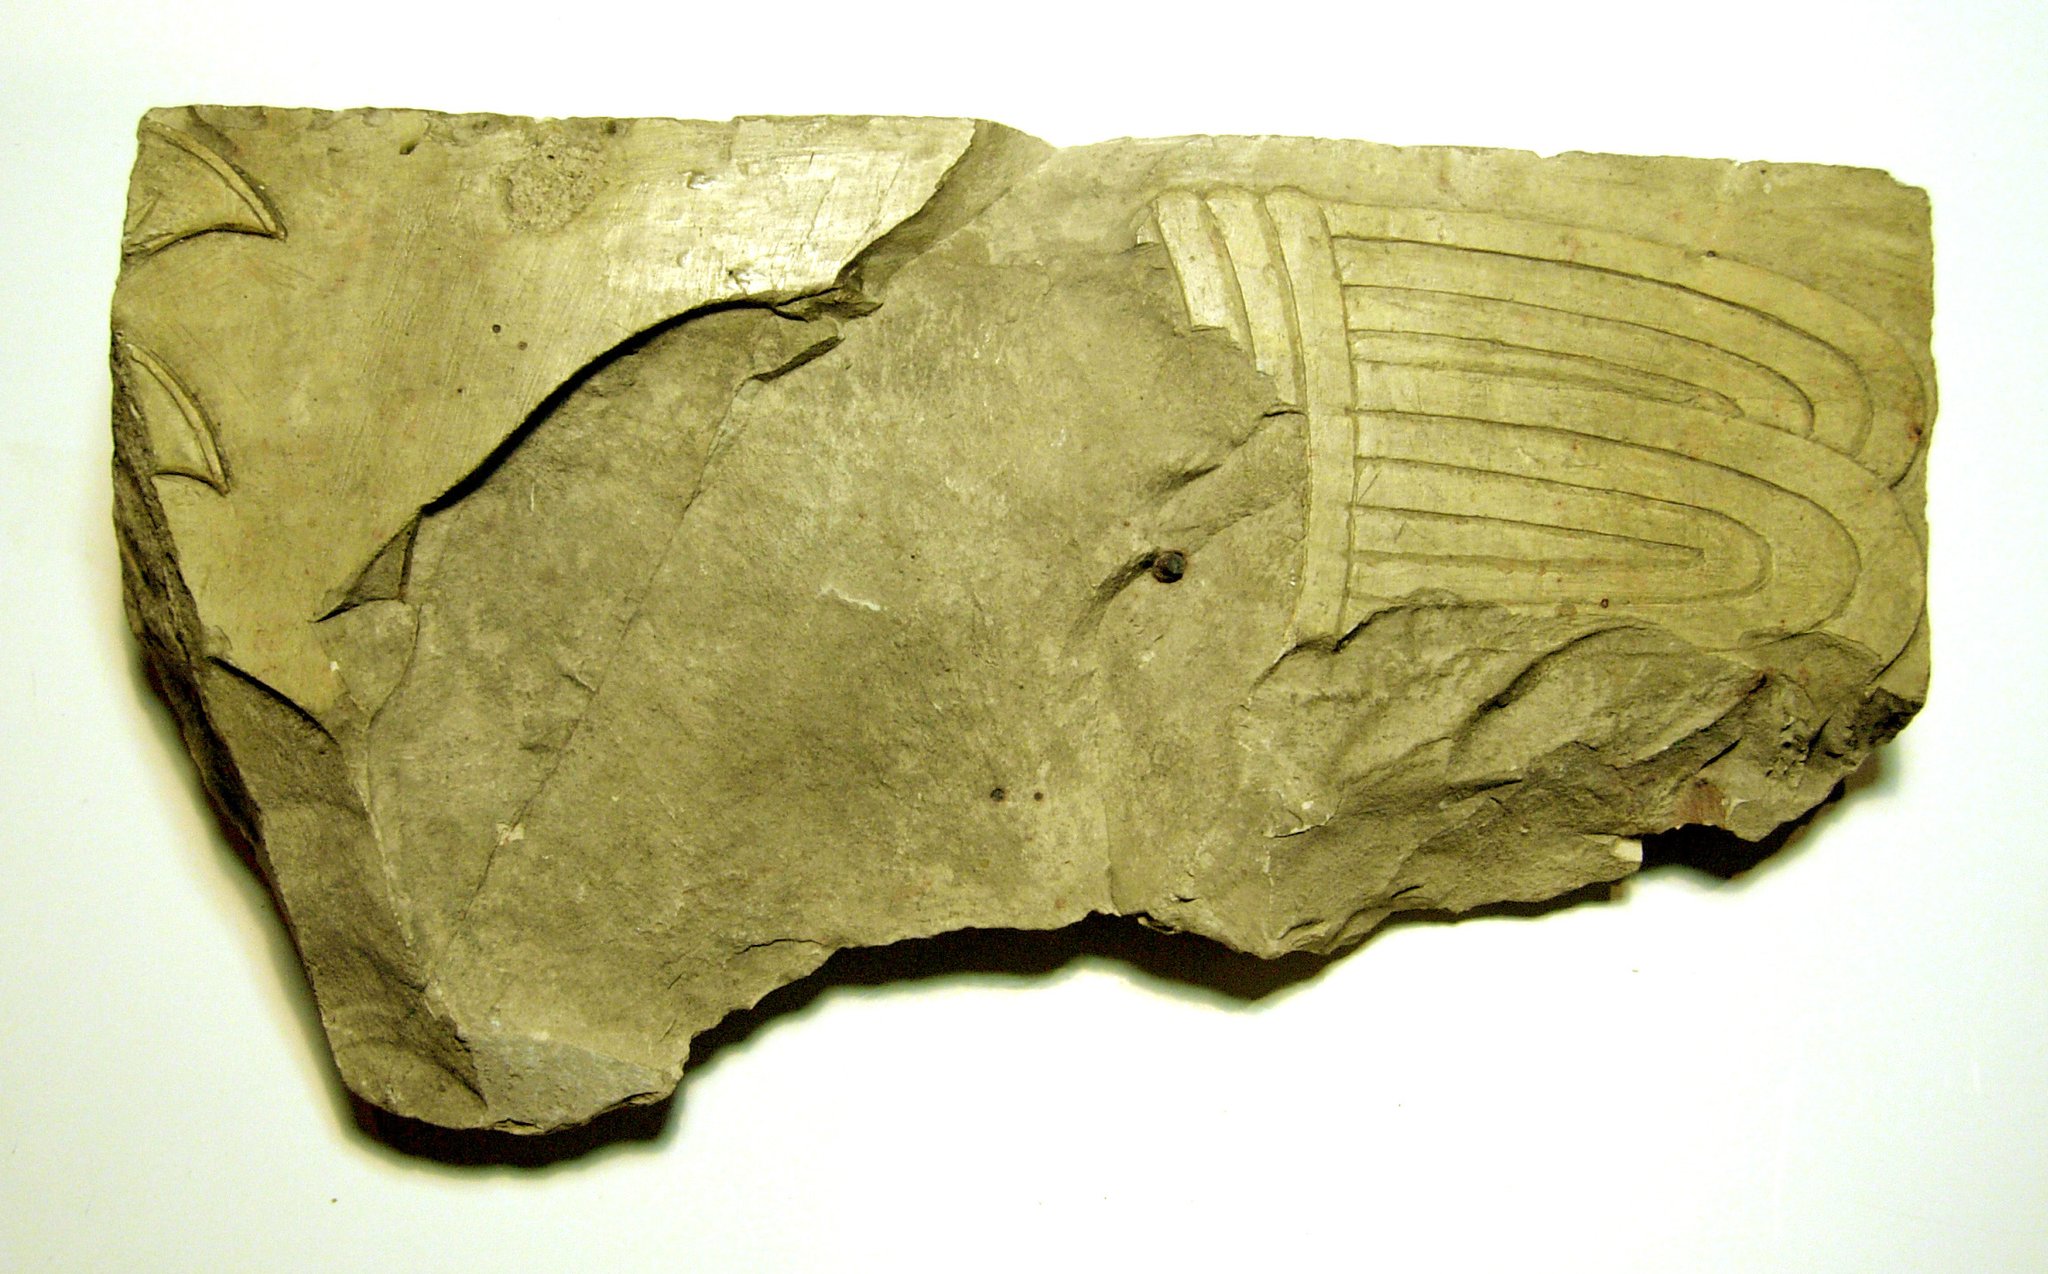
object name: relief, tomb of nespekashuty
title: Raised relief fragment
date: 664-610 BCE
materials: limestone, varnish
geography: egypt